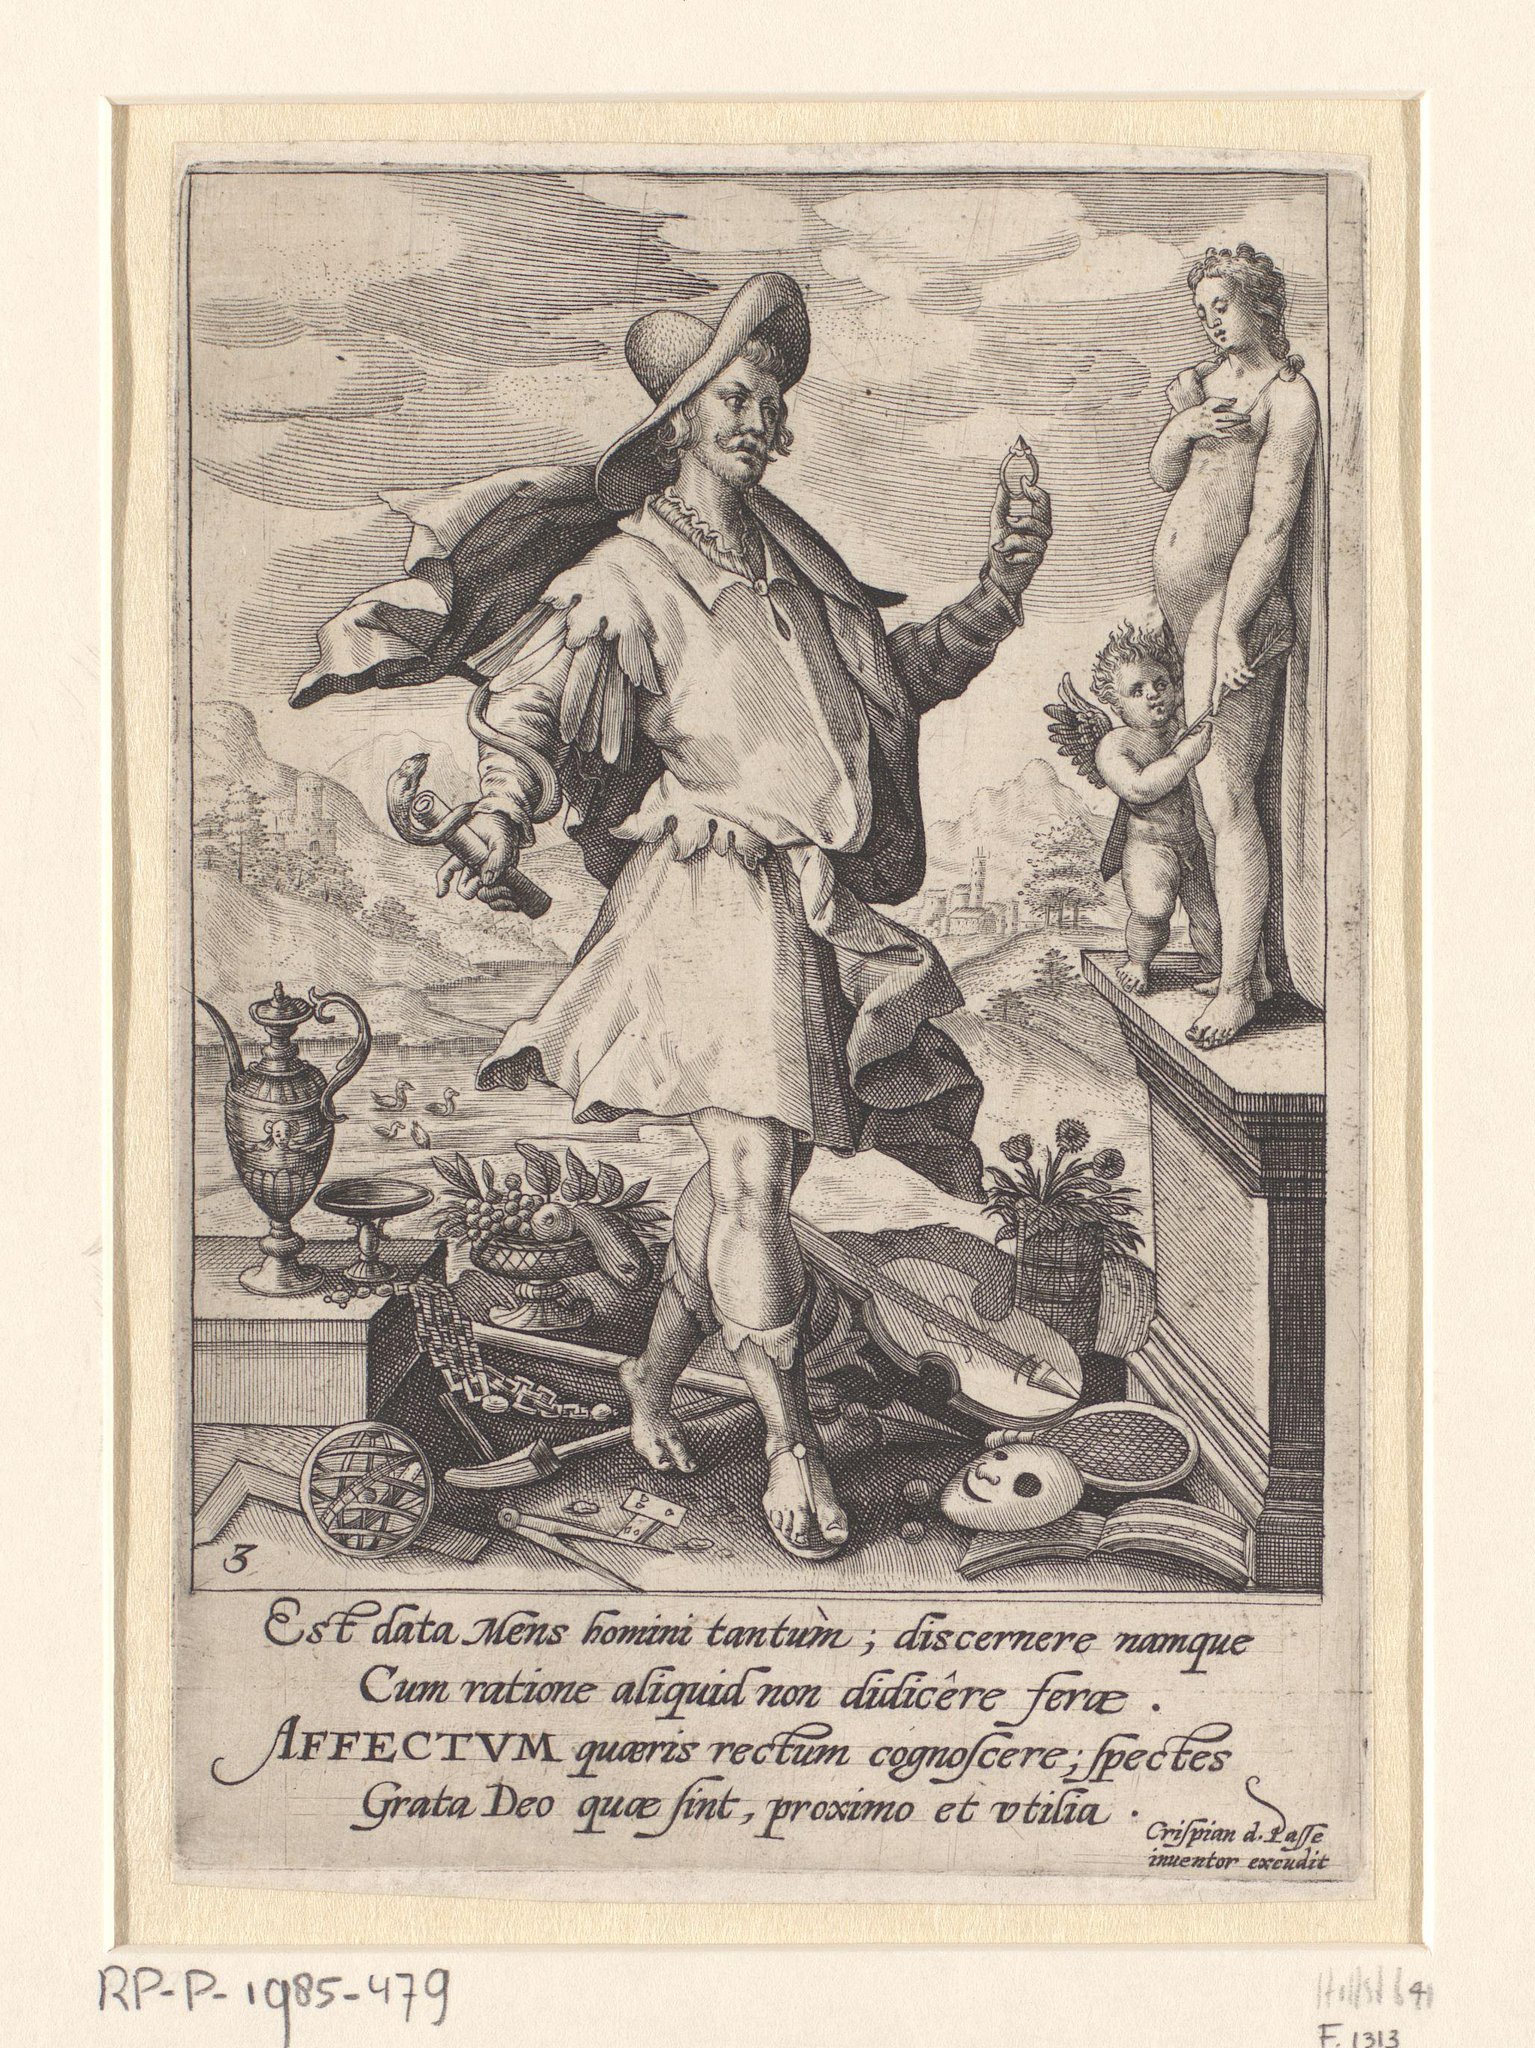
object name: print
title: De rede van de mens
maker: crispijn van de passe (i)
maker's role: draughtsman, print maker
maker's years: 1564-1637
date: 1589-1611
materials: paper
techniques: engraving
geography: cologne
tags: instruments ~ popular music, reasoning, snakes, reason versus amorous lust; 'combattimento della ragione con l'appetito' (ripa), fruits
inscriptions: collector's mark: Lugt 2760, number: ‘3’, collector's mark: Lugt 2228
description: De mens te midden van voorwerpen die de mogelijkheden van het leven symboliseren. Hij bestudeert een ring die hij in de linkerhand houdt. In het leven moet men een keuze maken tussen het navolgen van zijn passies (gepersonifieerd door Venus en Amor), zijn tijdelijke behoeftes (de wijn en het fruit), uiterlijk vermaak (de speelkaarten, het masker, het tennisracket) of kennis (de passer, de schaaf, het zangboek en de winkelhaak). De slang die rond zijn hand is gedraaid, symboliseert de rede die hem kan helpen bij het maken van zijn keuze.